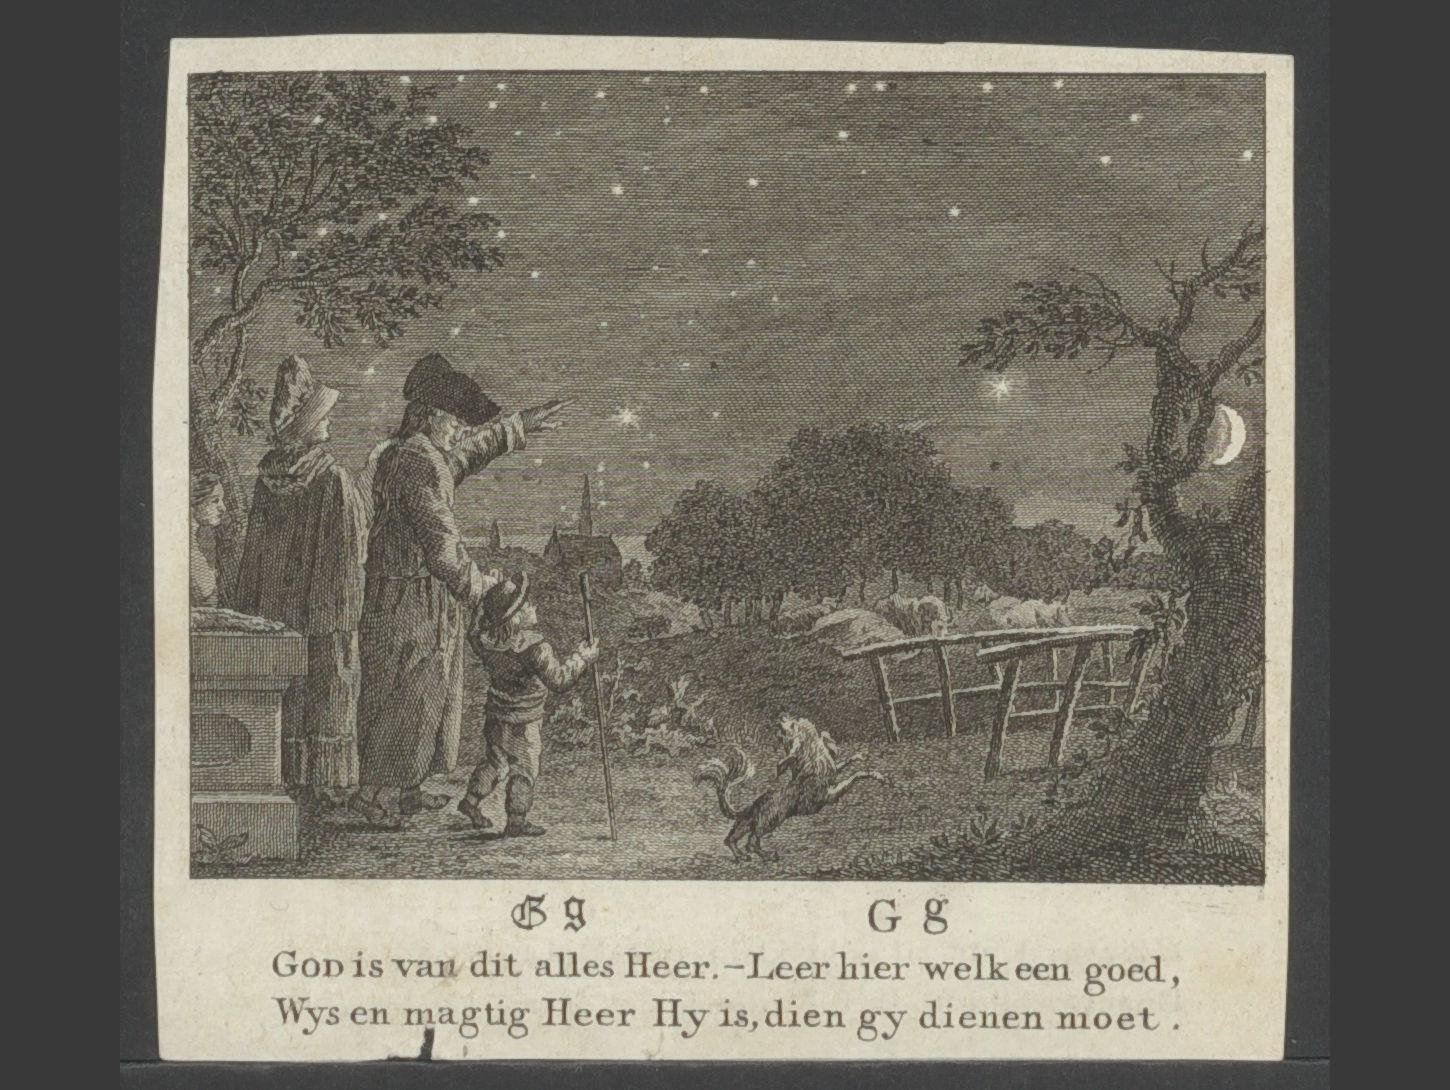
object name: print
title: God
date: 1781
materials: paper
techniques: engraving, etching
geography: amsterdam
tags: god the father, letters, alphabet, script, stars and constellations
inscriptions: collector's mark: Lugt 1641, stamp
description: Gezin op een open vlakte. De vader wijst naar sterren in de hemel. Onder de voorstelling de letter G in twee verschillende lettertypes. Onderaan een tweeregelig vers over God. Onderwerpsrubrieken binnen de Atlas Zeden en Gewoonten: Onderwijs en Wetenschappen, Opvoeding en Onderwijs, Haneboeken en schoolprenten.